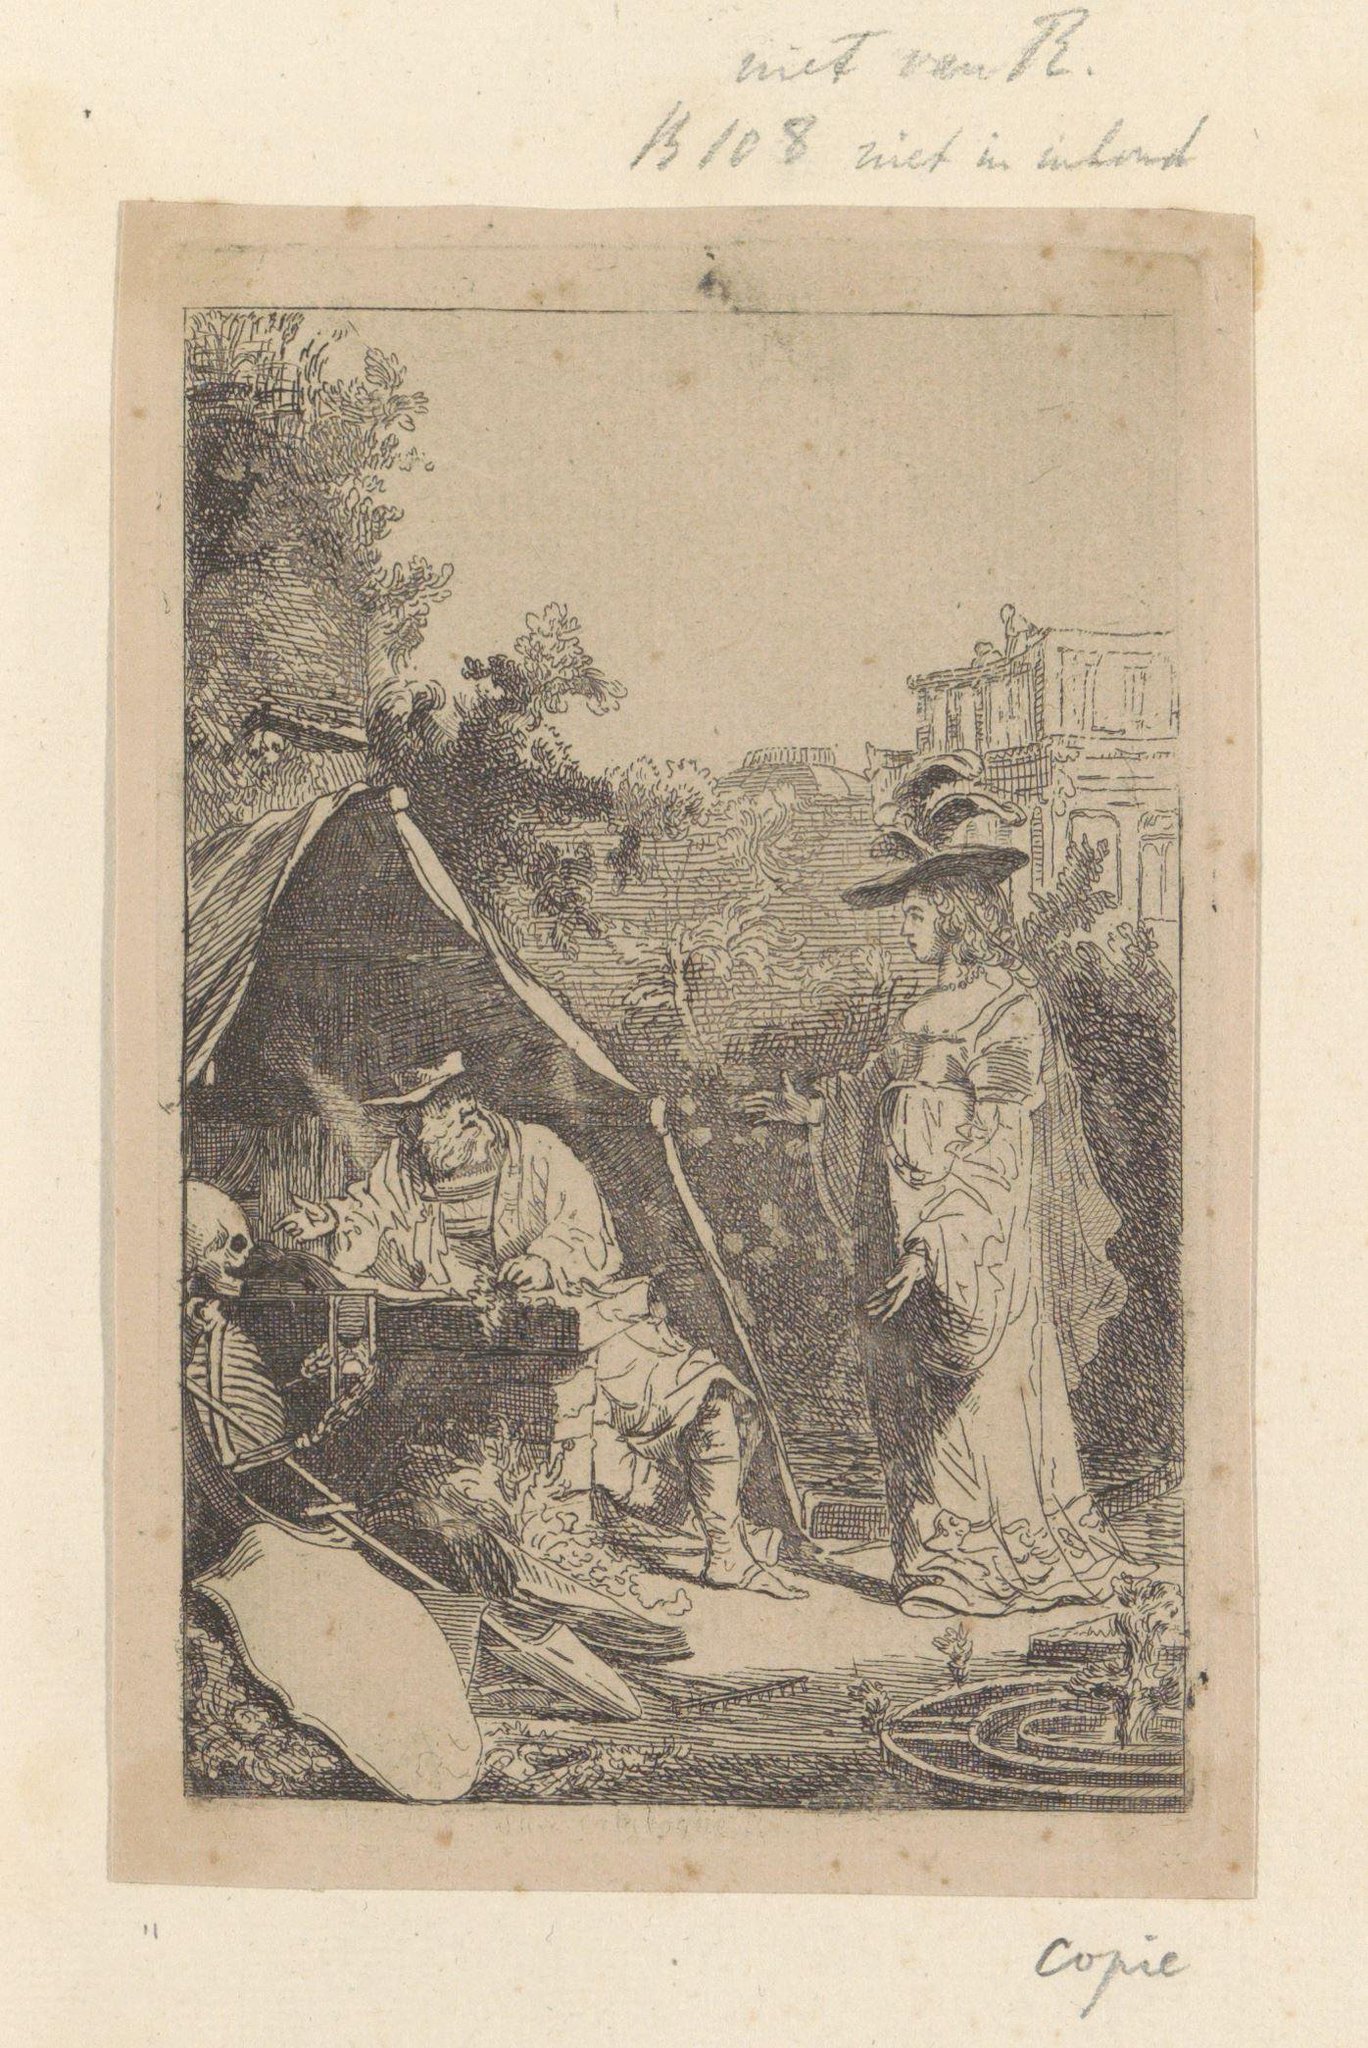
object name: print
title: Recueil de quatre-vingt-cinq estampes originales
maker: henry louis basan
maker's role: printer, publisher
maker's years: -1819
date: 1644-1807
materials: paper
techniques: etching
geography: paris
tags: death as skeleton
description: Een hoveling trekt zich terug voor bezinning in de tuin van het paleis. Het skelet van de Dood zit naast hem. Een courtisane probeert hem te verleiden maar hij geeft niet toe aan aardse lusten. Hij bekeert haar tot een kuise levenswijze. De prent maakt deel uit van een album.